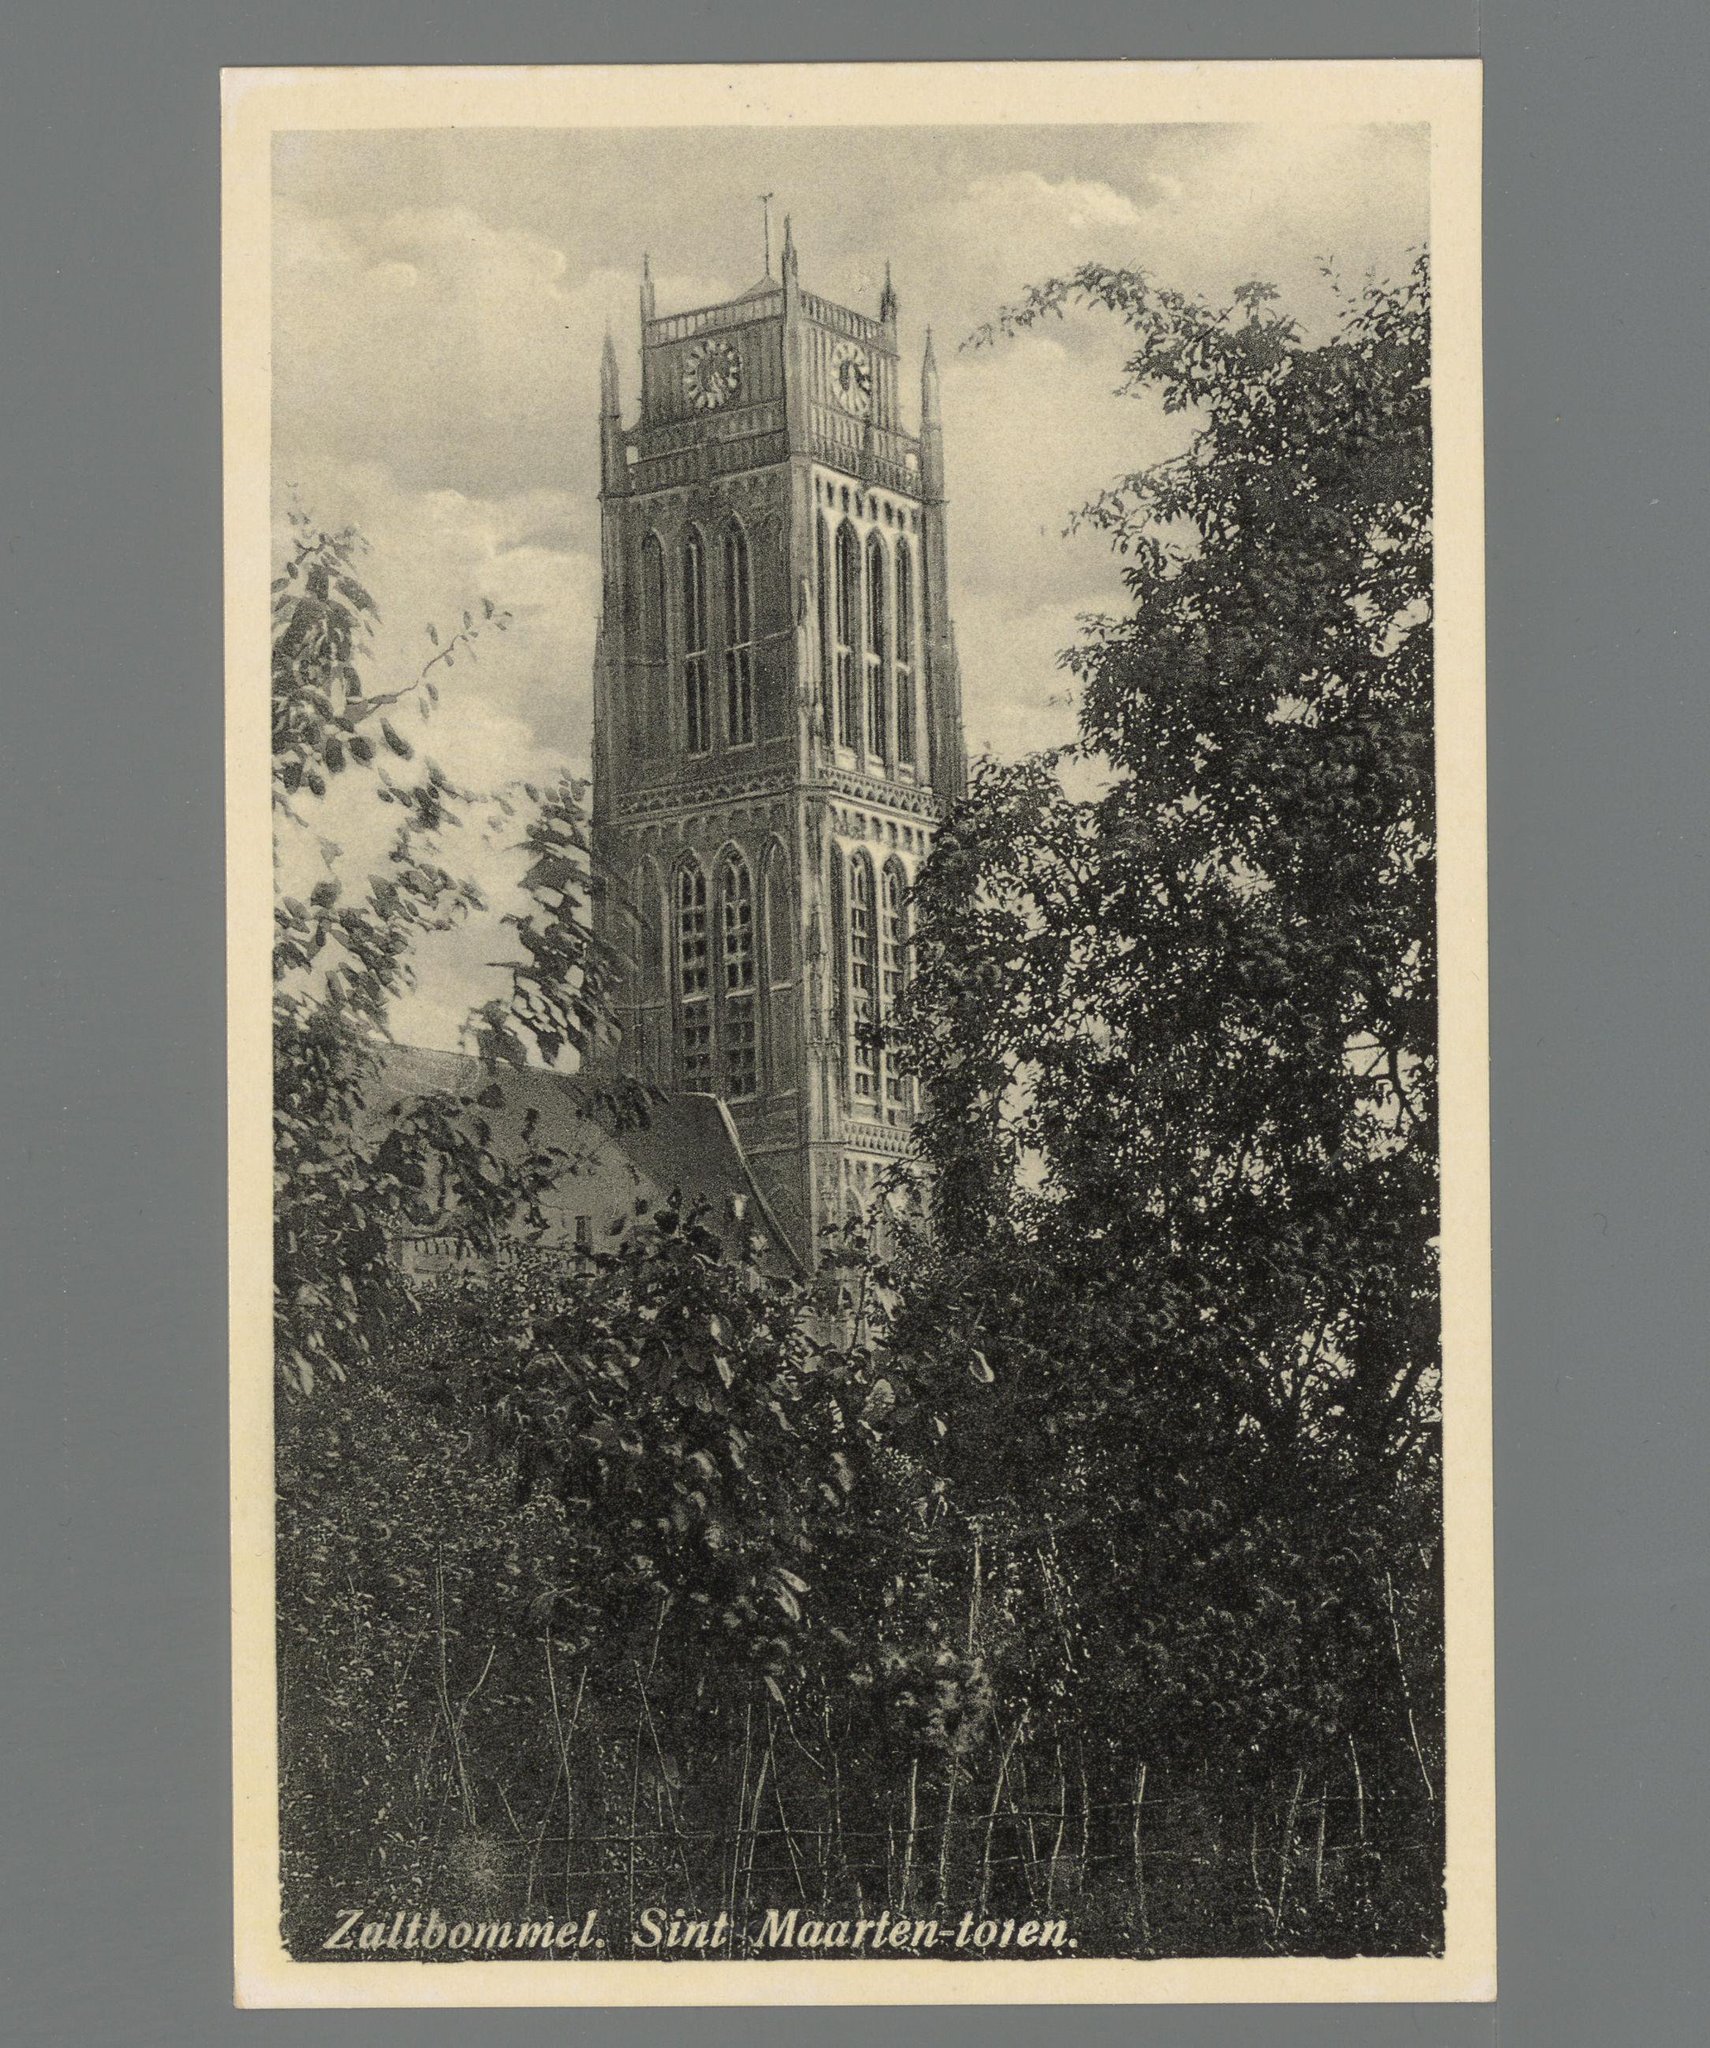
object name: ansichtkaart, prentbriefkaart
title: Zaltbommel. Sint Maarten-toren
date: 1913-1950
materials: cardboard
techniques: photograph, writing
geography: zaltbommel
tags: church (exterior)